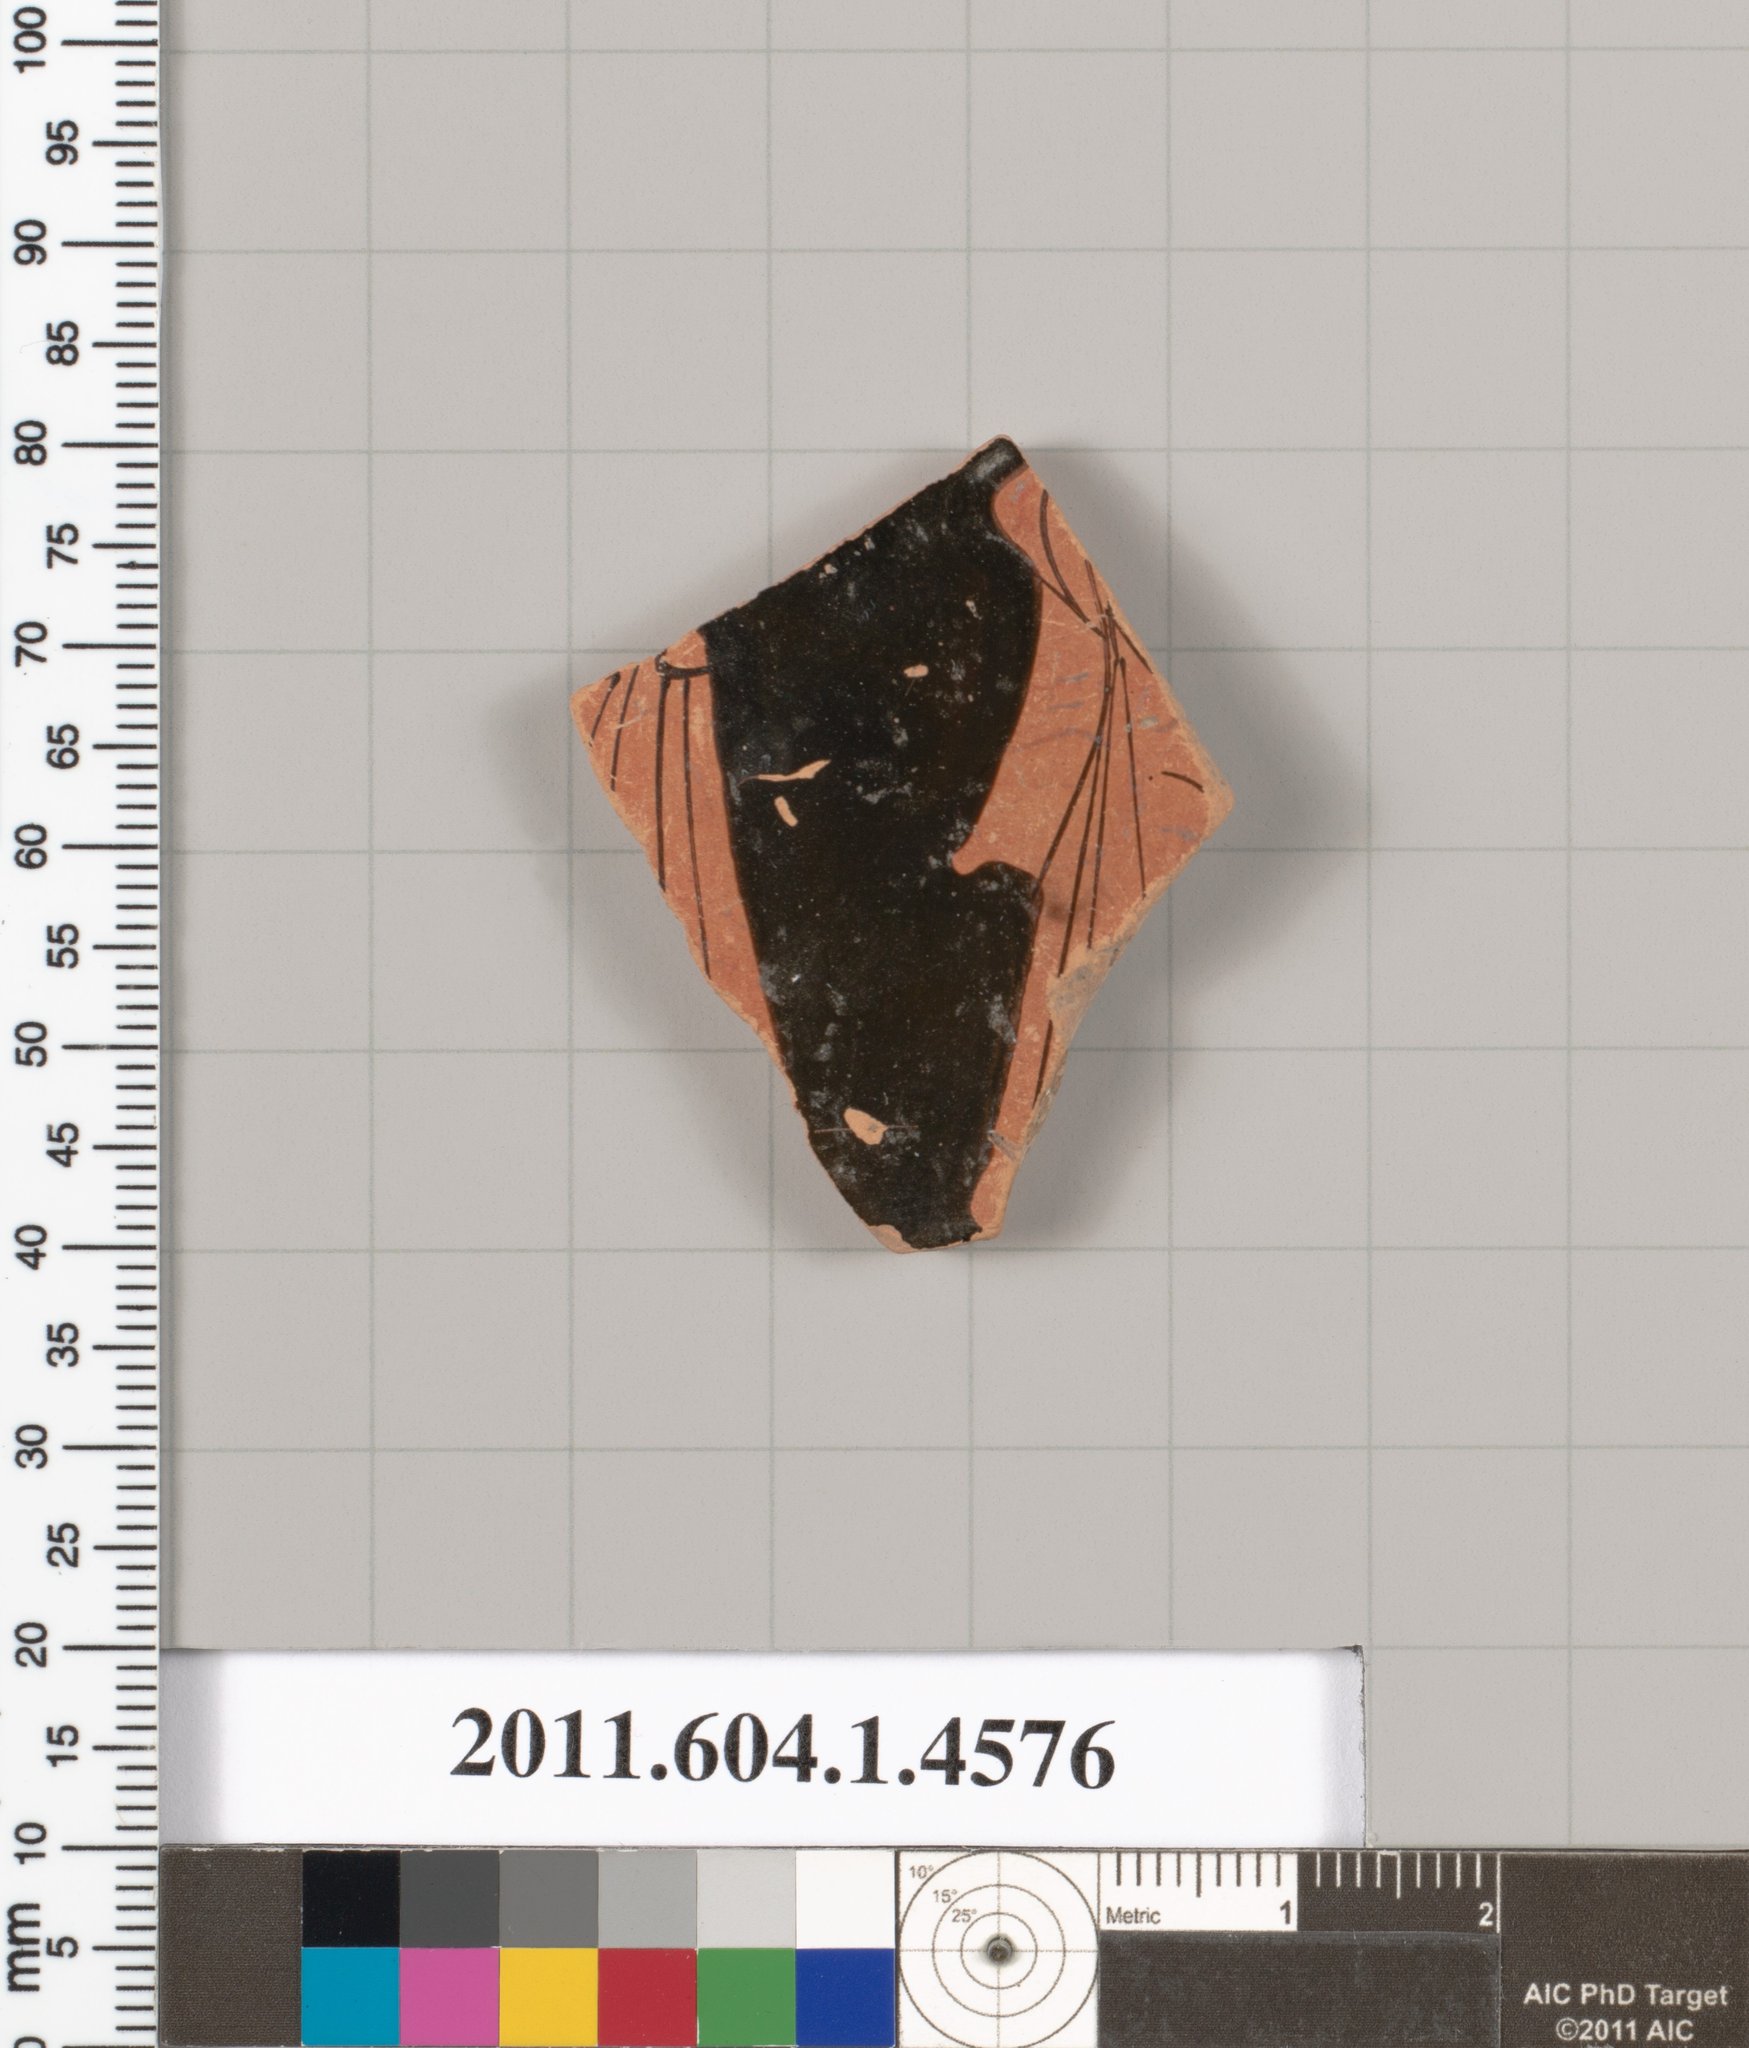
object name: kylix fragment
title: Terracotta fragment of a kylix (drinking cup)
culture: greek, attic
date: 475-451 BCE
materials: terracotta